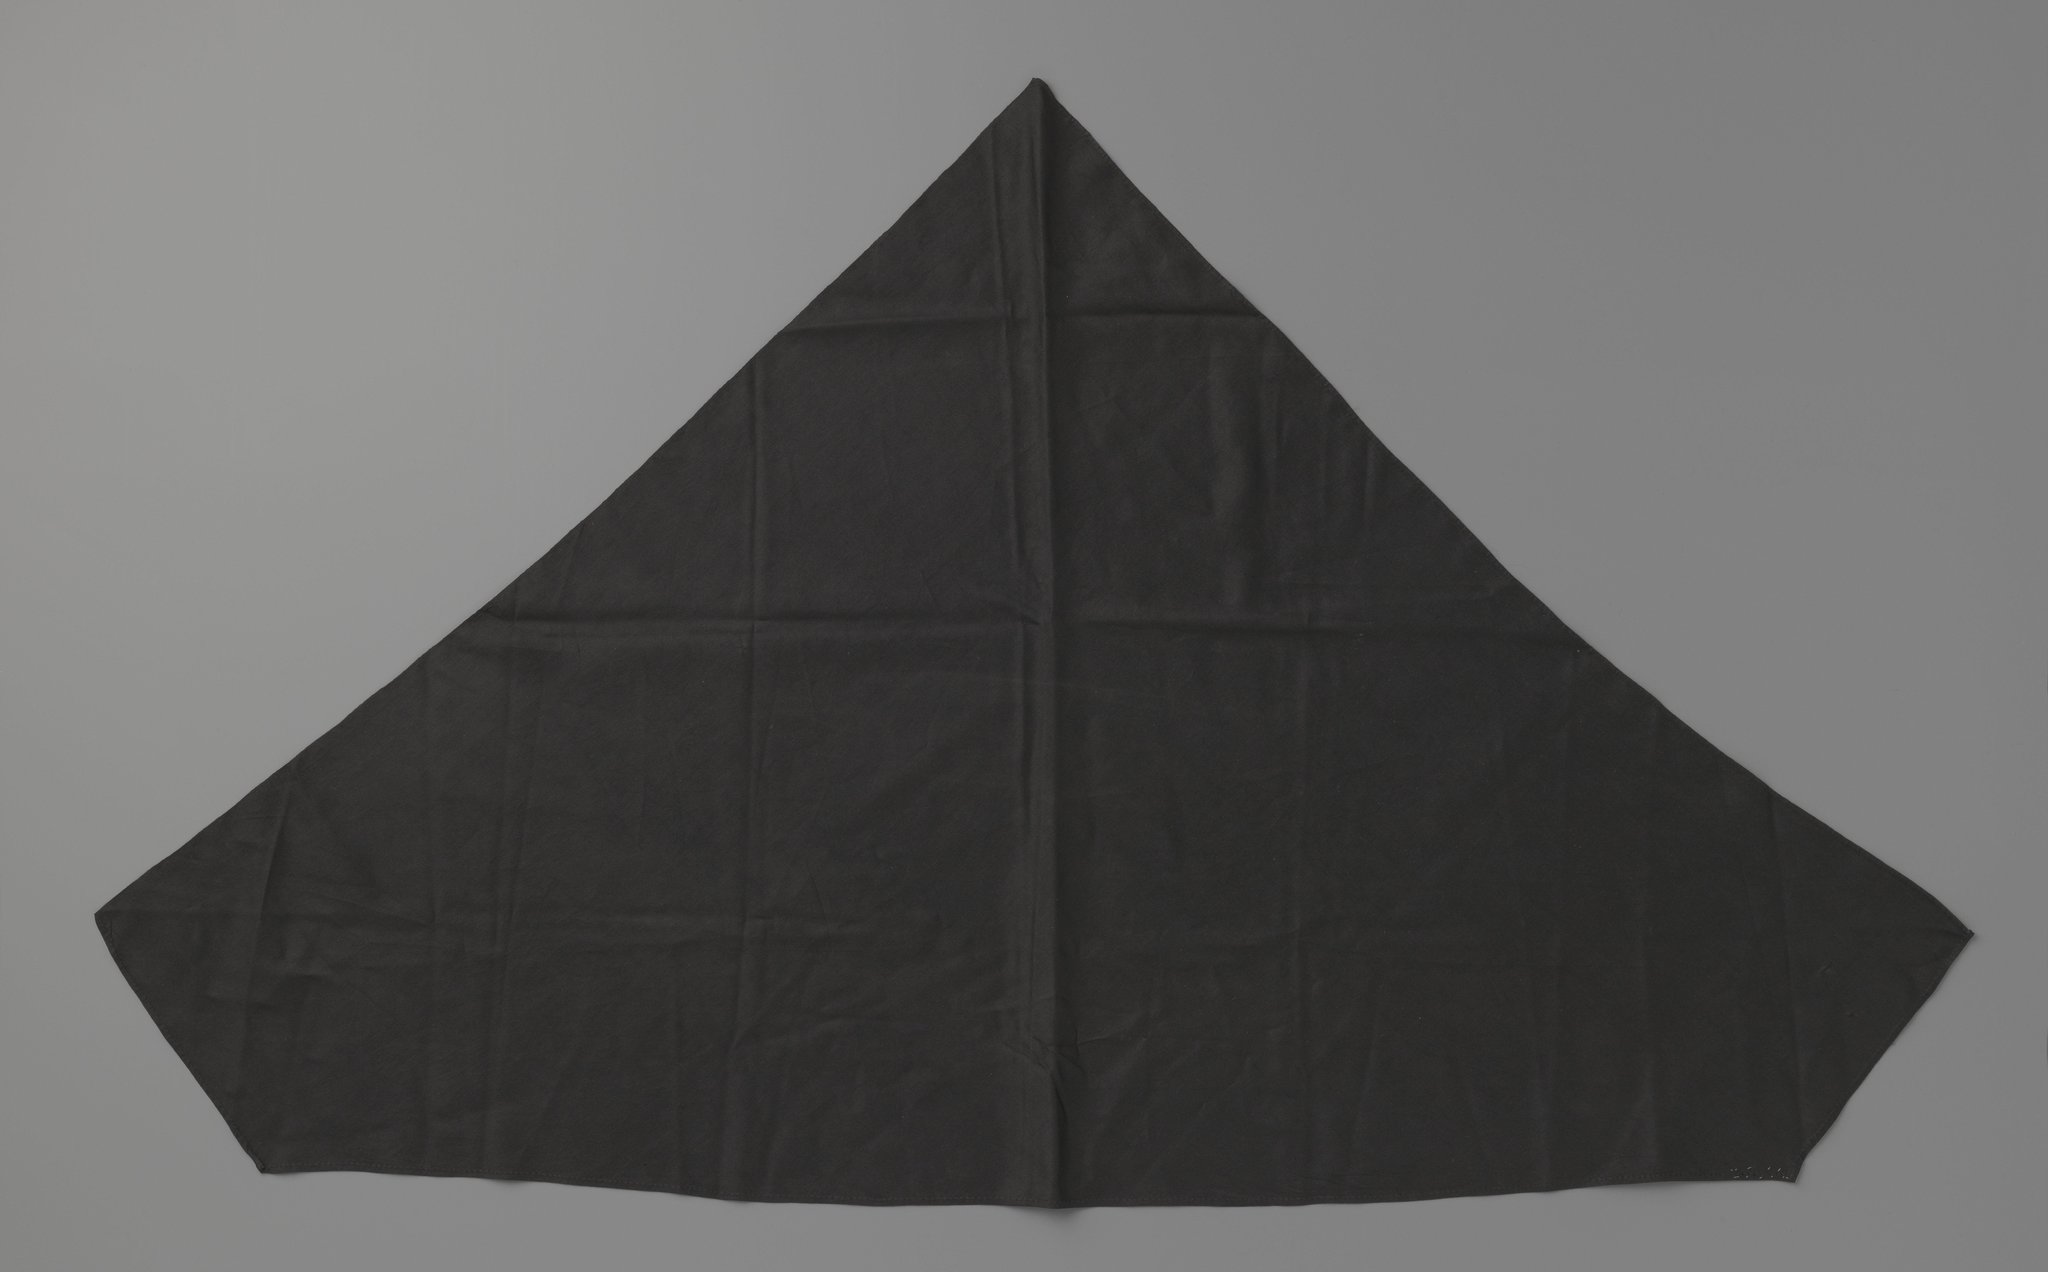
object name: clothing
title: Diamantvormige sjaal in effen zwarte zijde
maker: Anonymous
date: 1920-1940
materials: silk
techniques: weave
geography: netherlands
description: Diamantvormige sjaal in effen zwarte zijde.